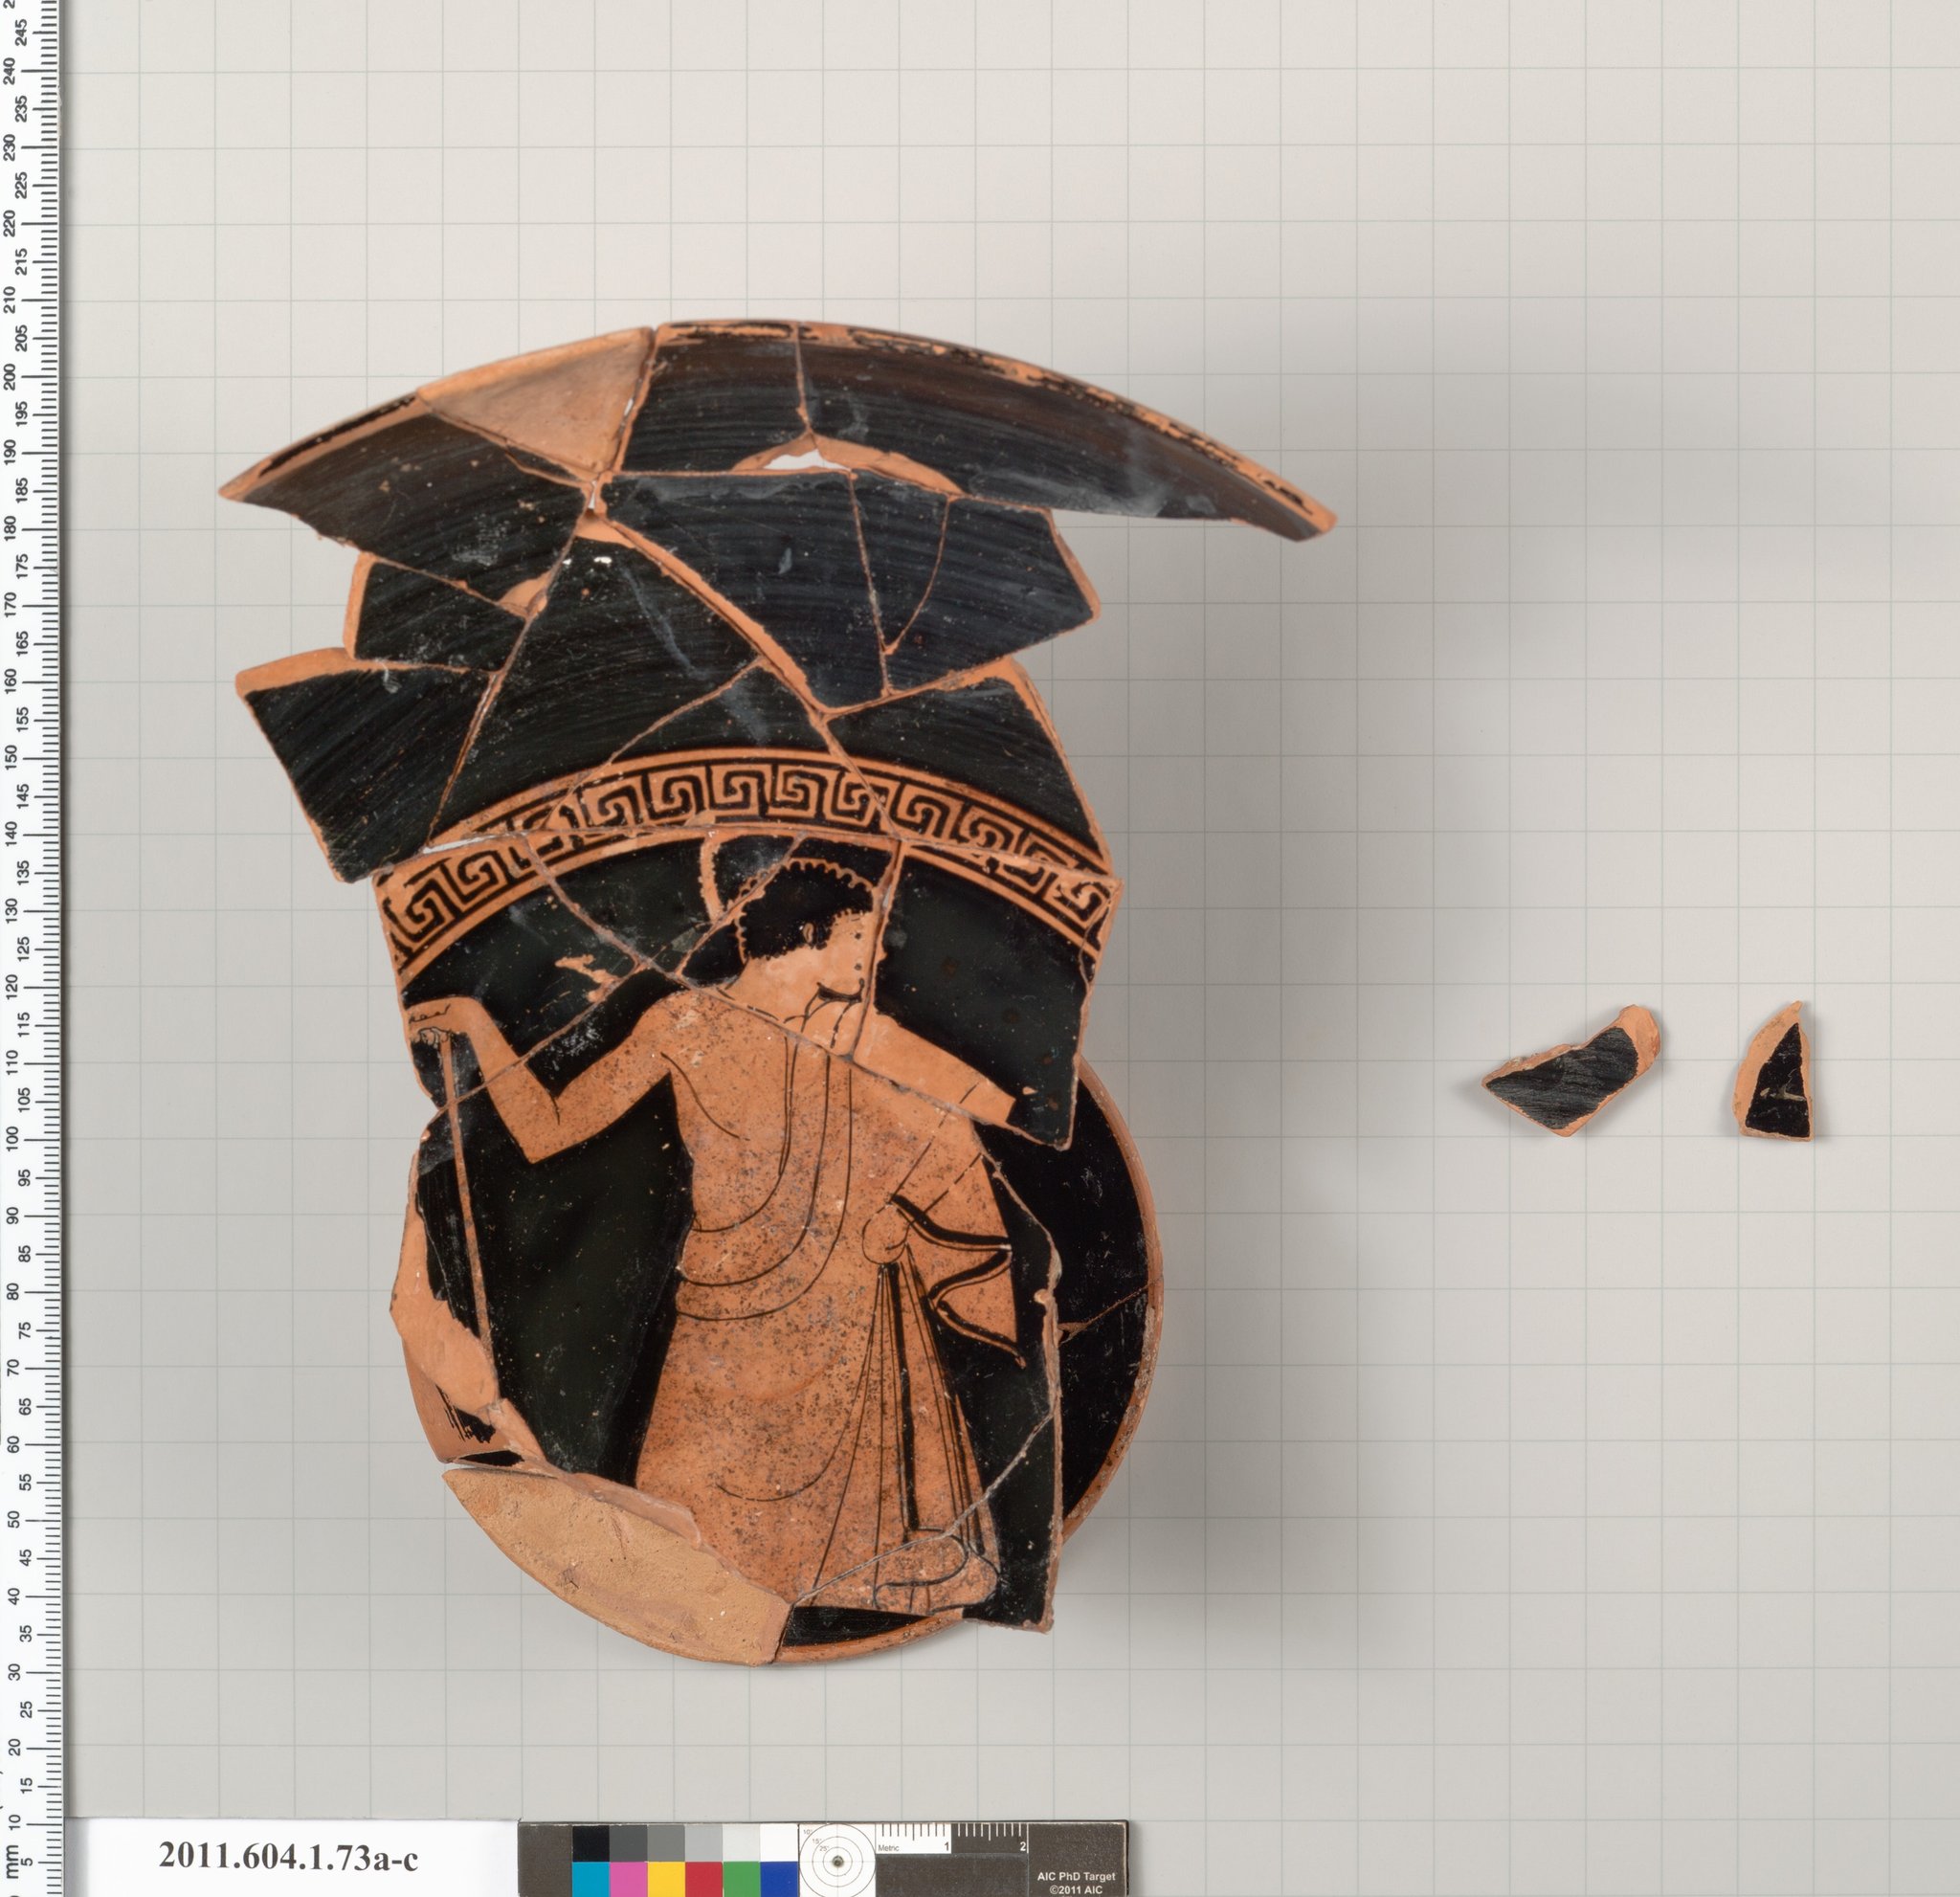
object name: kylix fragment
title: Terracotta fragments of a kylix (drinking cup)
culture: greek, attic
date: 480-470 BCE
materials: terracotta